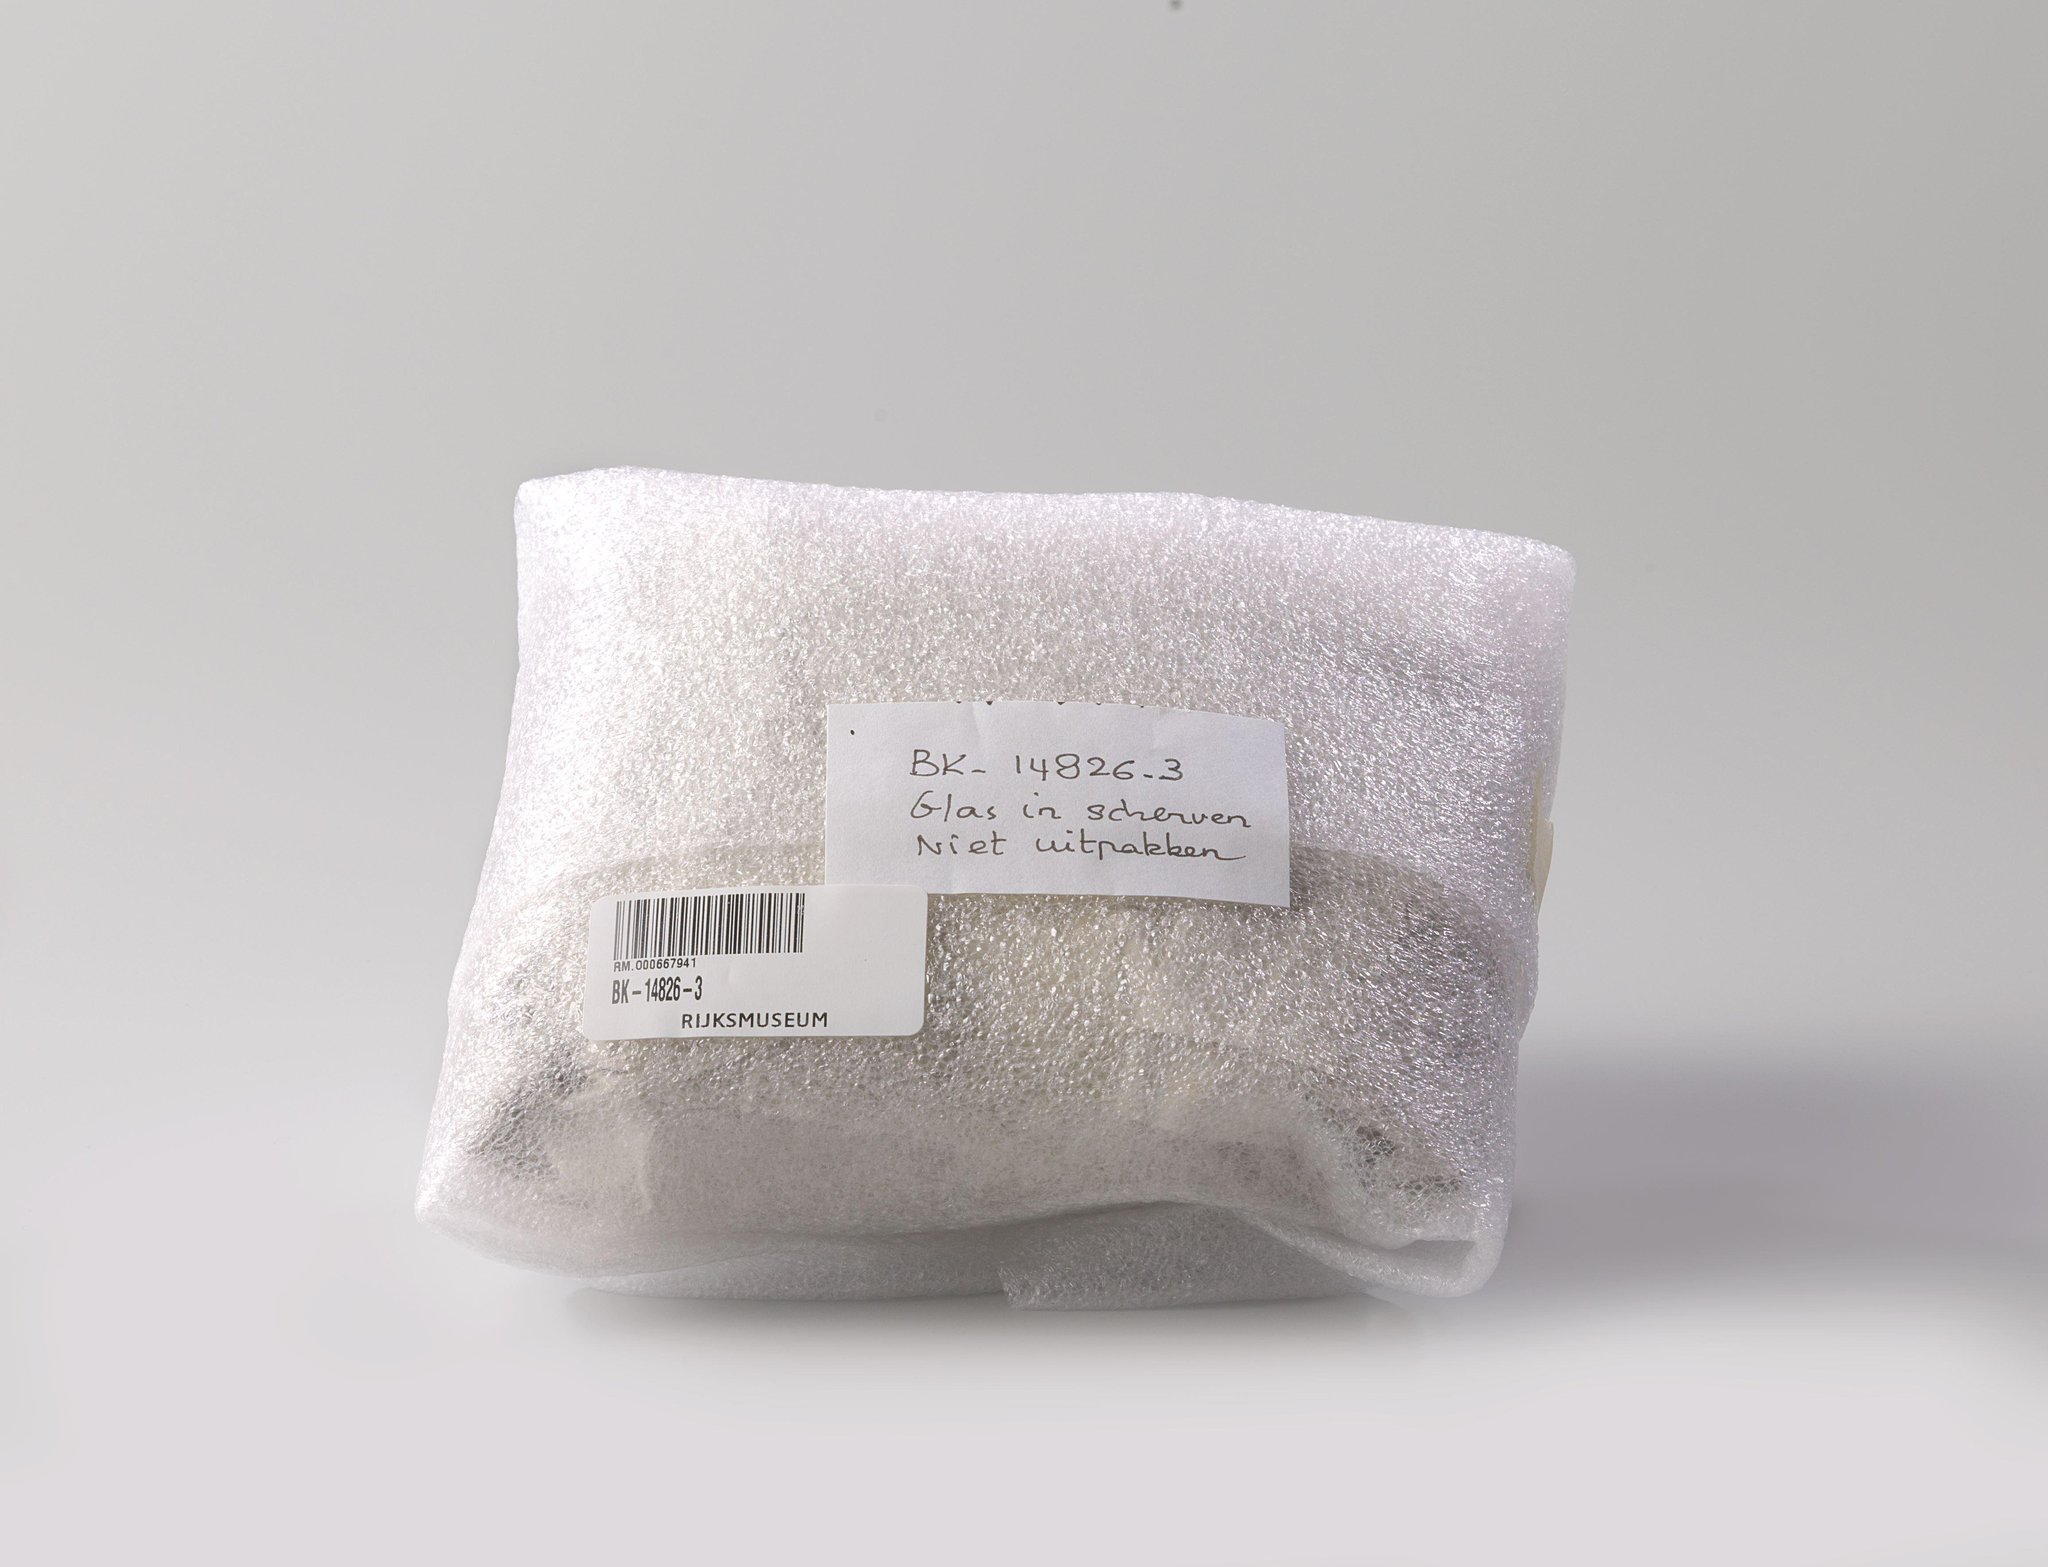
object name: goblet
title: Dubbelbokaal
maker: Anonymous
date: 1725-1750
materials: glass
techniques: glassblowing, grinding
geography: bohemia